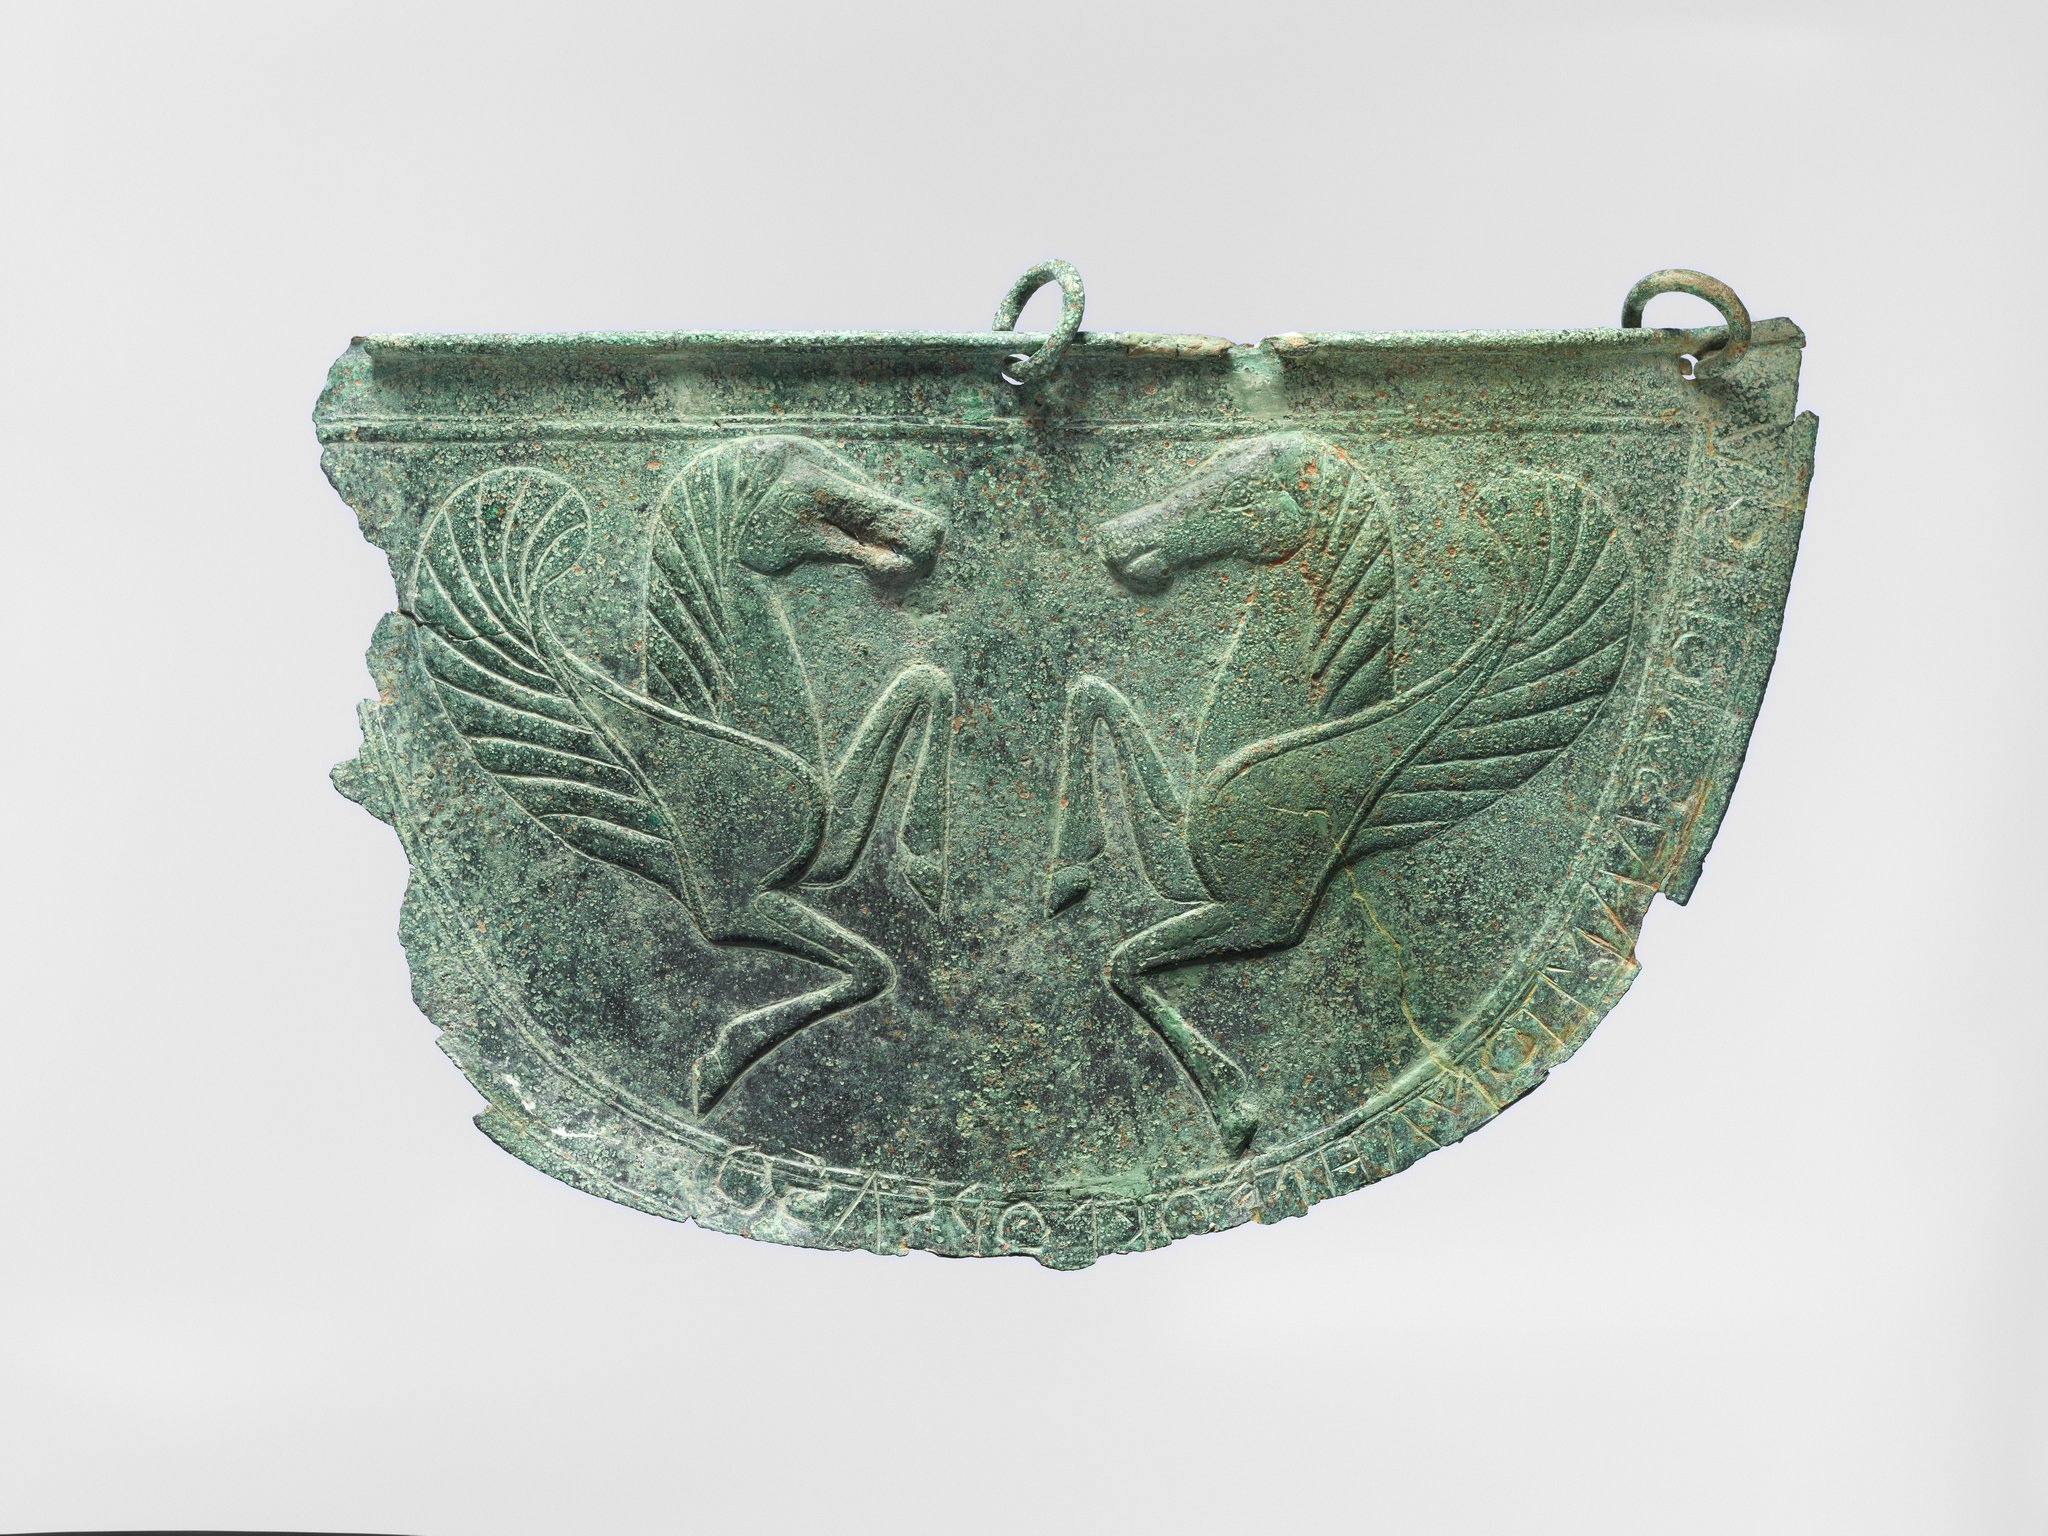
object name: mitra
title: Bronze mitra (belly guard)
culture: greek, cretan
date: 634-601 BCE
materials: bronze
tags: horses